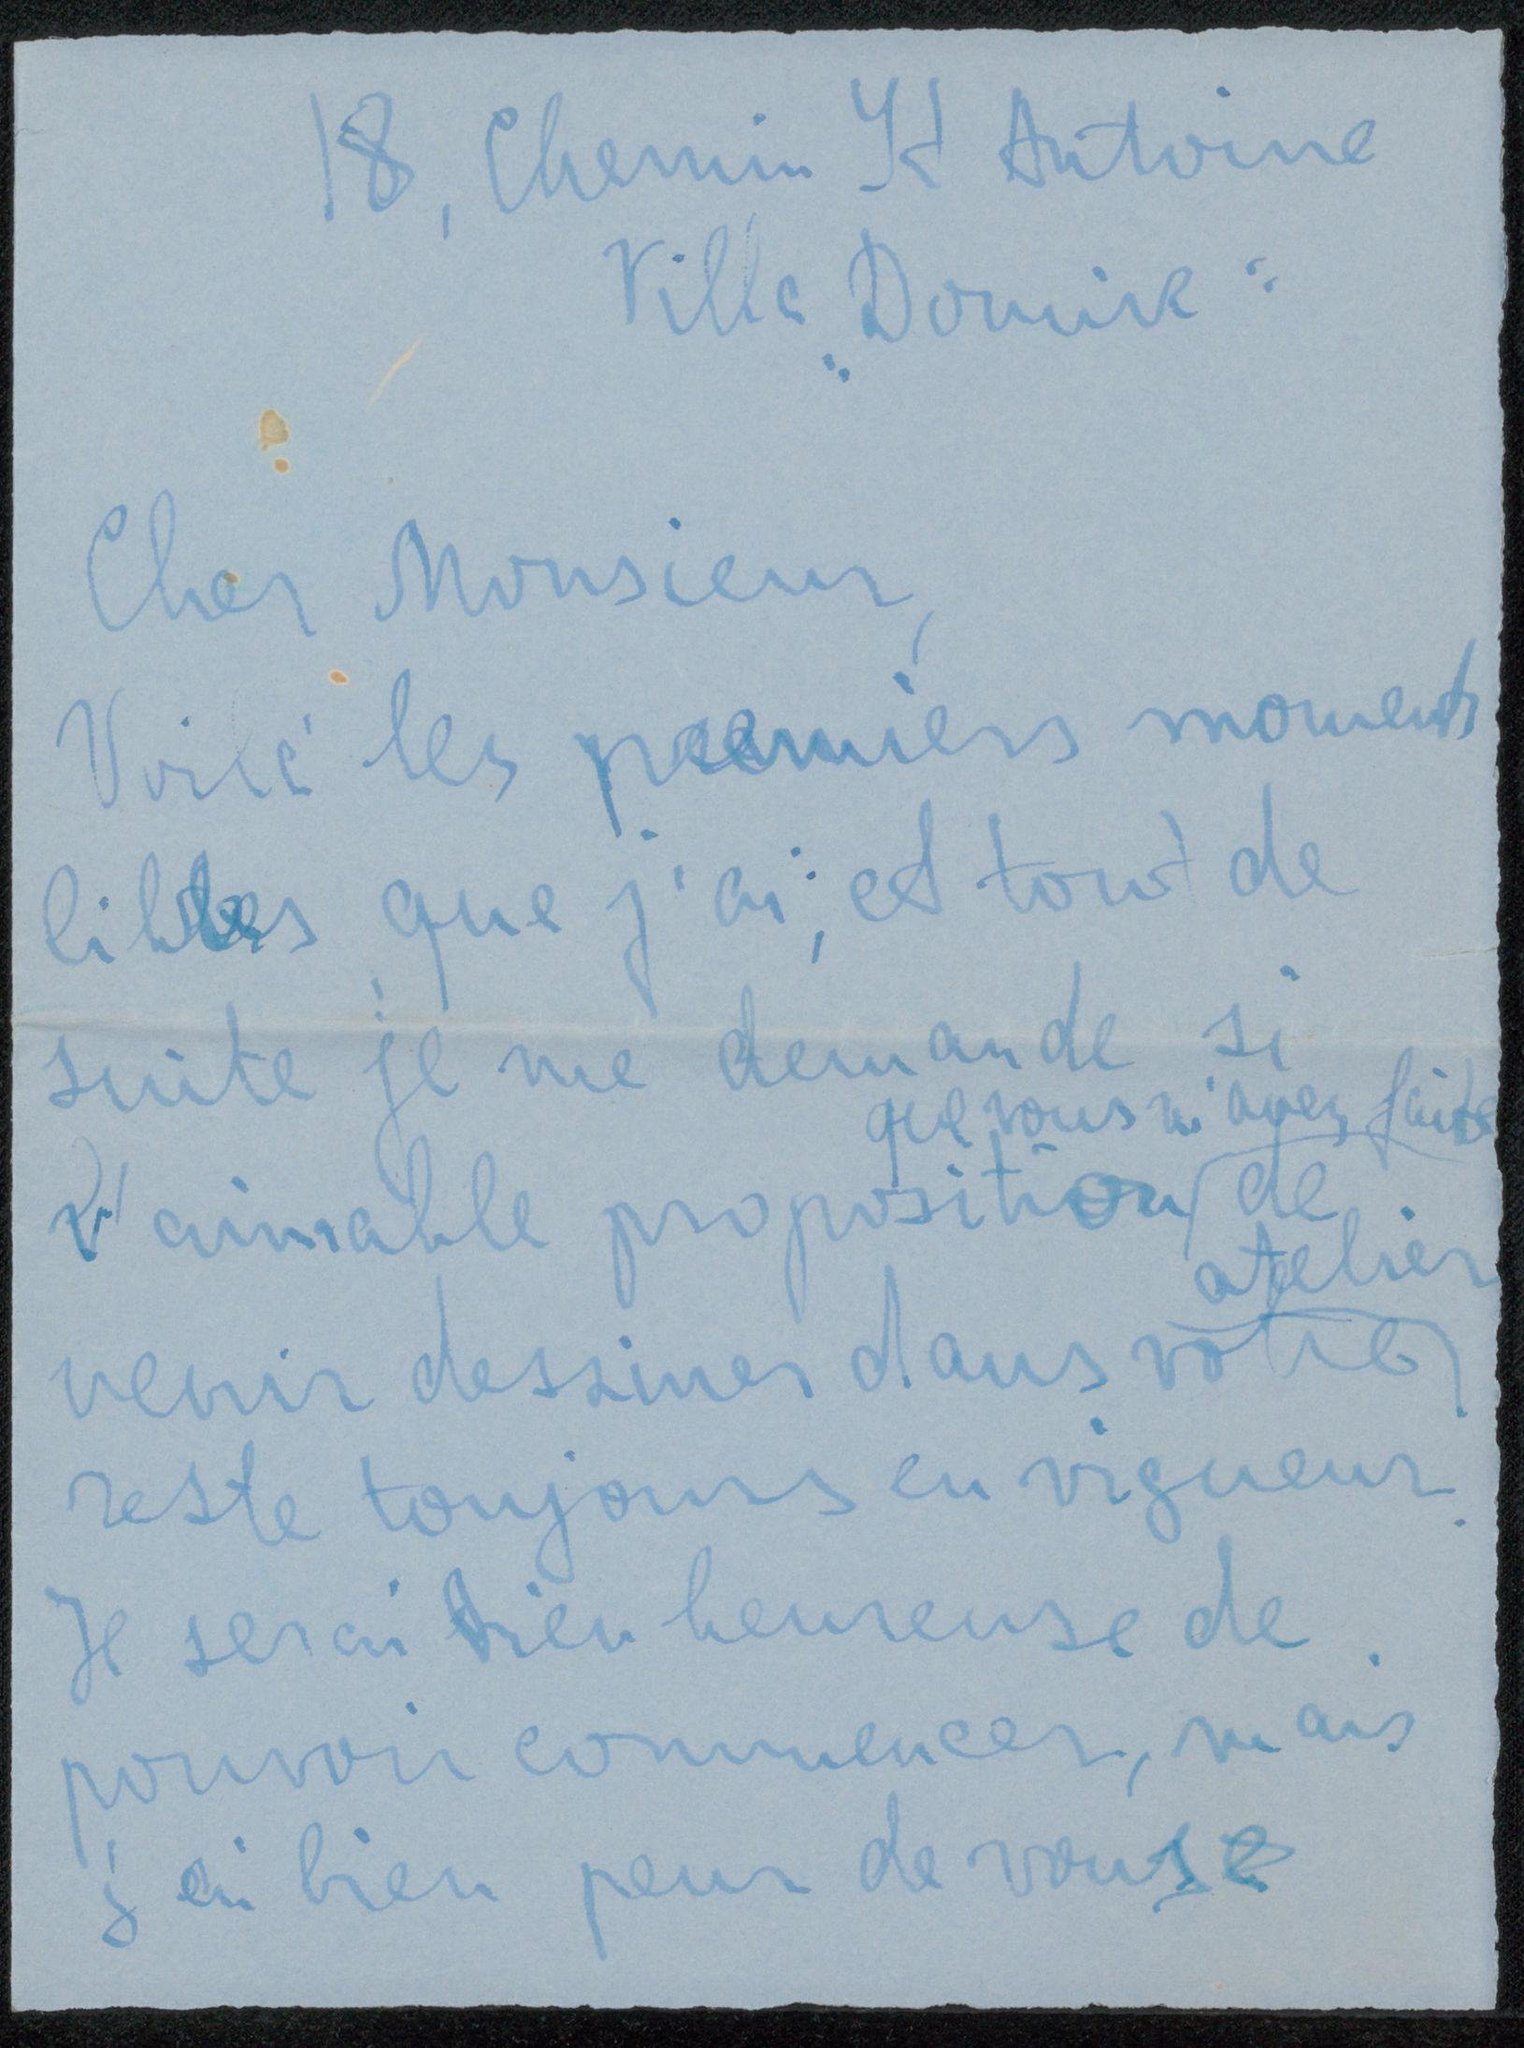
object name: letter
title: Brief aan Philip Zilcken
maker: marianne von der launitz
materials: ink, paper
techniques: pen, writing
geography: nice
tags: the hague, painter, draughtsman, philip zilcken, workshop, studio of the artist (in general)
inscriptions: collector's mark: ‘RPK’